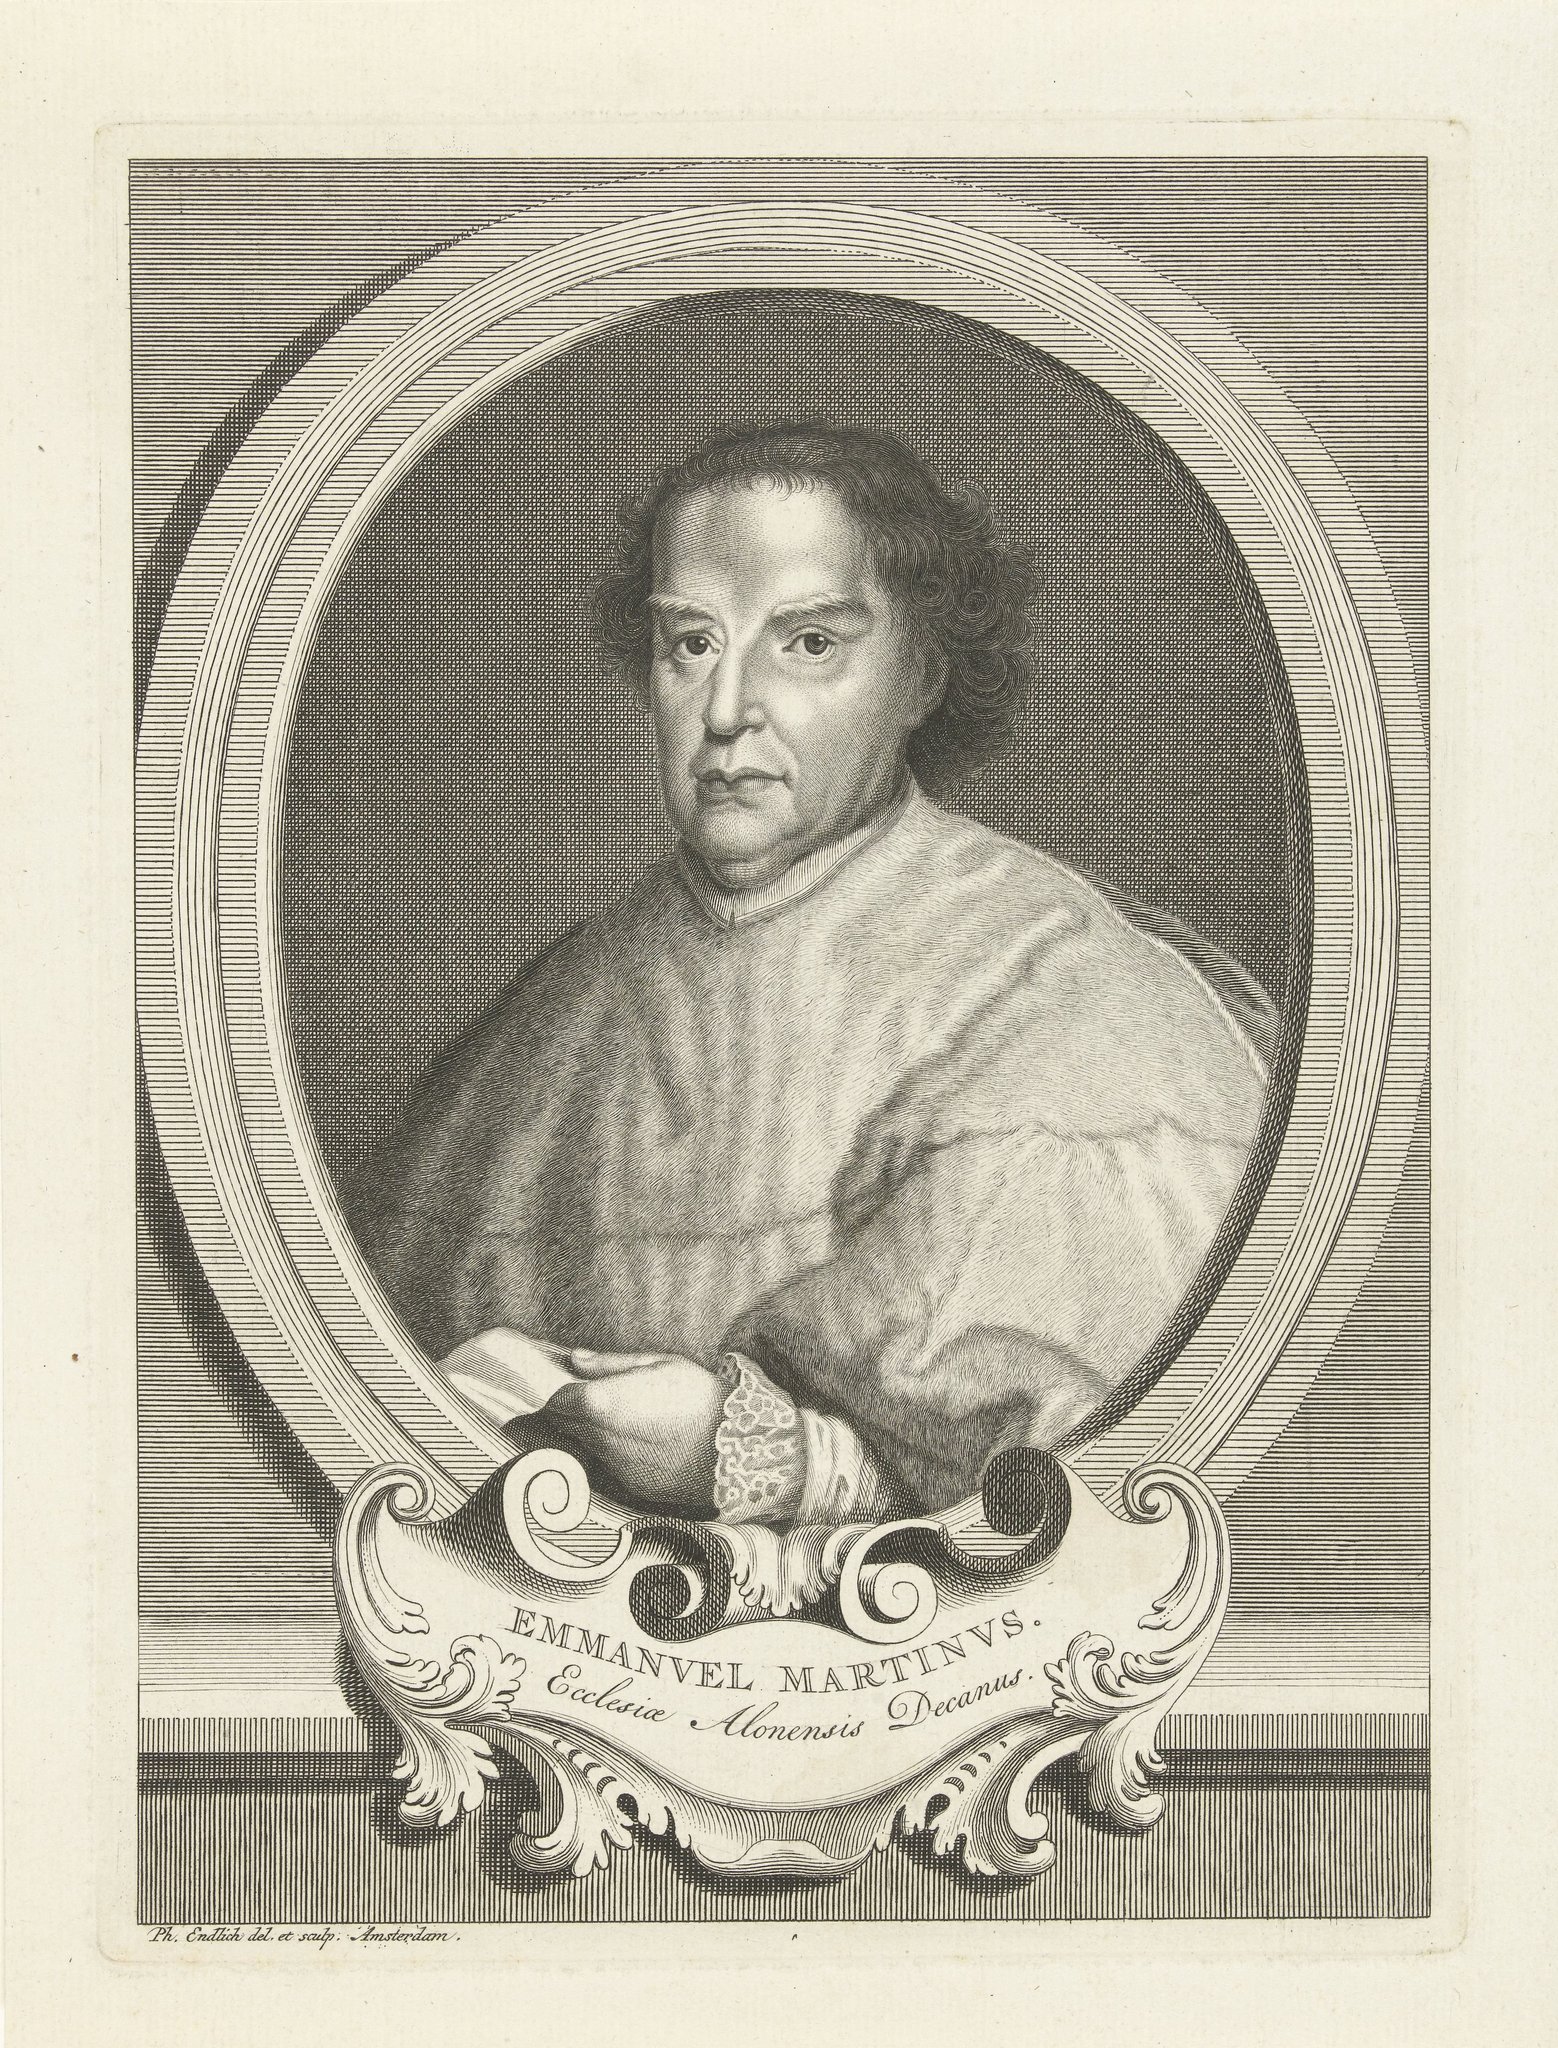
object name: print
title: EMMANVEL MARTINVS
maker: philippus endlich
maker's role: draughtsman, print maker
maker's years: 1700-1748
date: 1731-1748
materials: paper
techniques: engraving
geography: amsterdam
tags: deken, manuel marti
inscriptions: collector's mark: Lugt 2228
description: Portret van Manuel Marti (1663-1737) deken van Alicante, in bonten mantel, met document in de hand. Afgebeeld in ovale omlijsting met ornament.